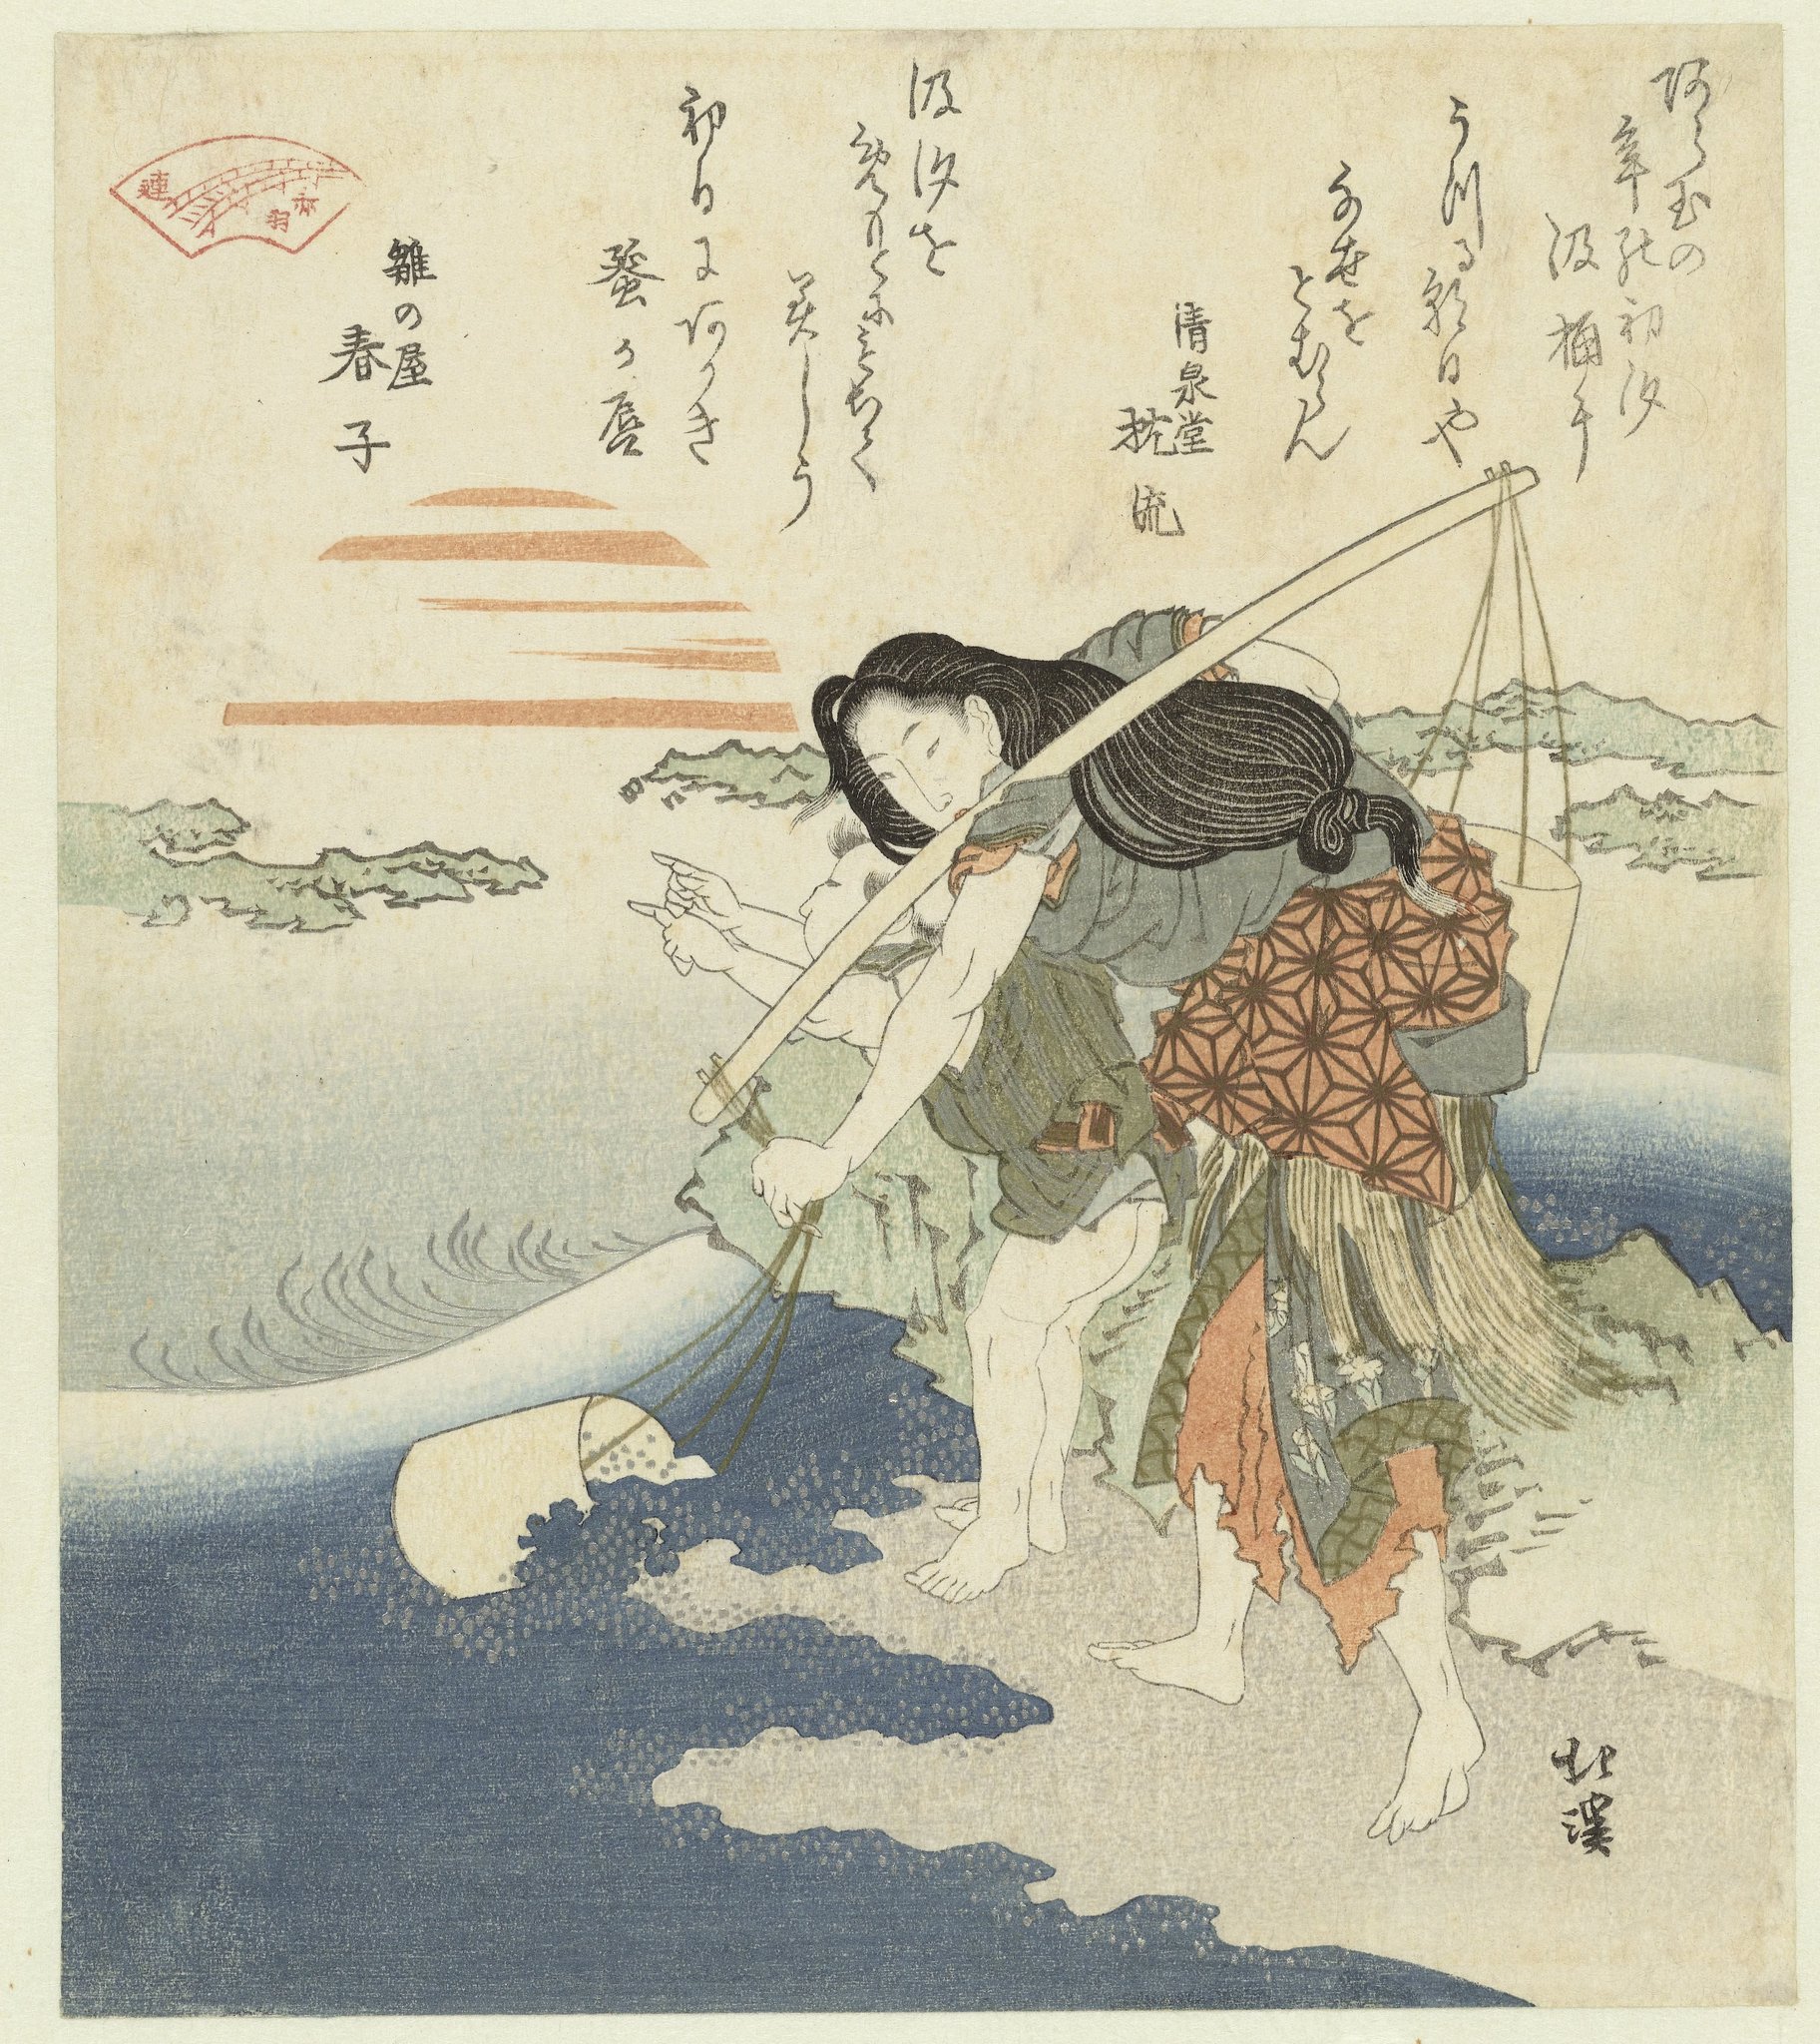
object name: surimono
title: Zoutwaterputten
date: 1827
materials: paper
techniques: blind stamped, woodcut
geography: japan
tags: sunrise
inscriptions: collector's mark, verso, stamped: Lugt 2228, collector's mark, passe-partout, bottom left, printed: JABdH with a rooster.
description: Een surimono is een luxe uitgevoerde prent waarop beeld met één of meerdere gedichten gecombineerd is. Bij het drukken van een surimono werd vaak gebruik gemaakt van dikker papier, blinddruk en metaal pigmenten, zoals koper- en zilverpoeder. De prenten werden vaak in opdracht van dichters gemaakt en als exclusief geschenk aan vrienden en relaties gegeven.